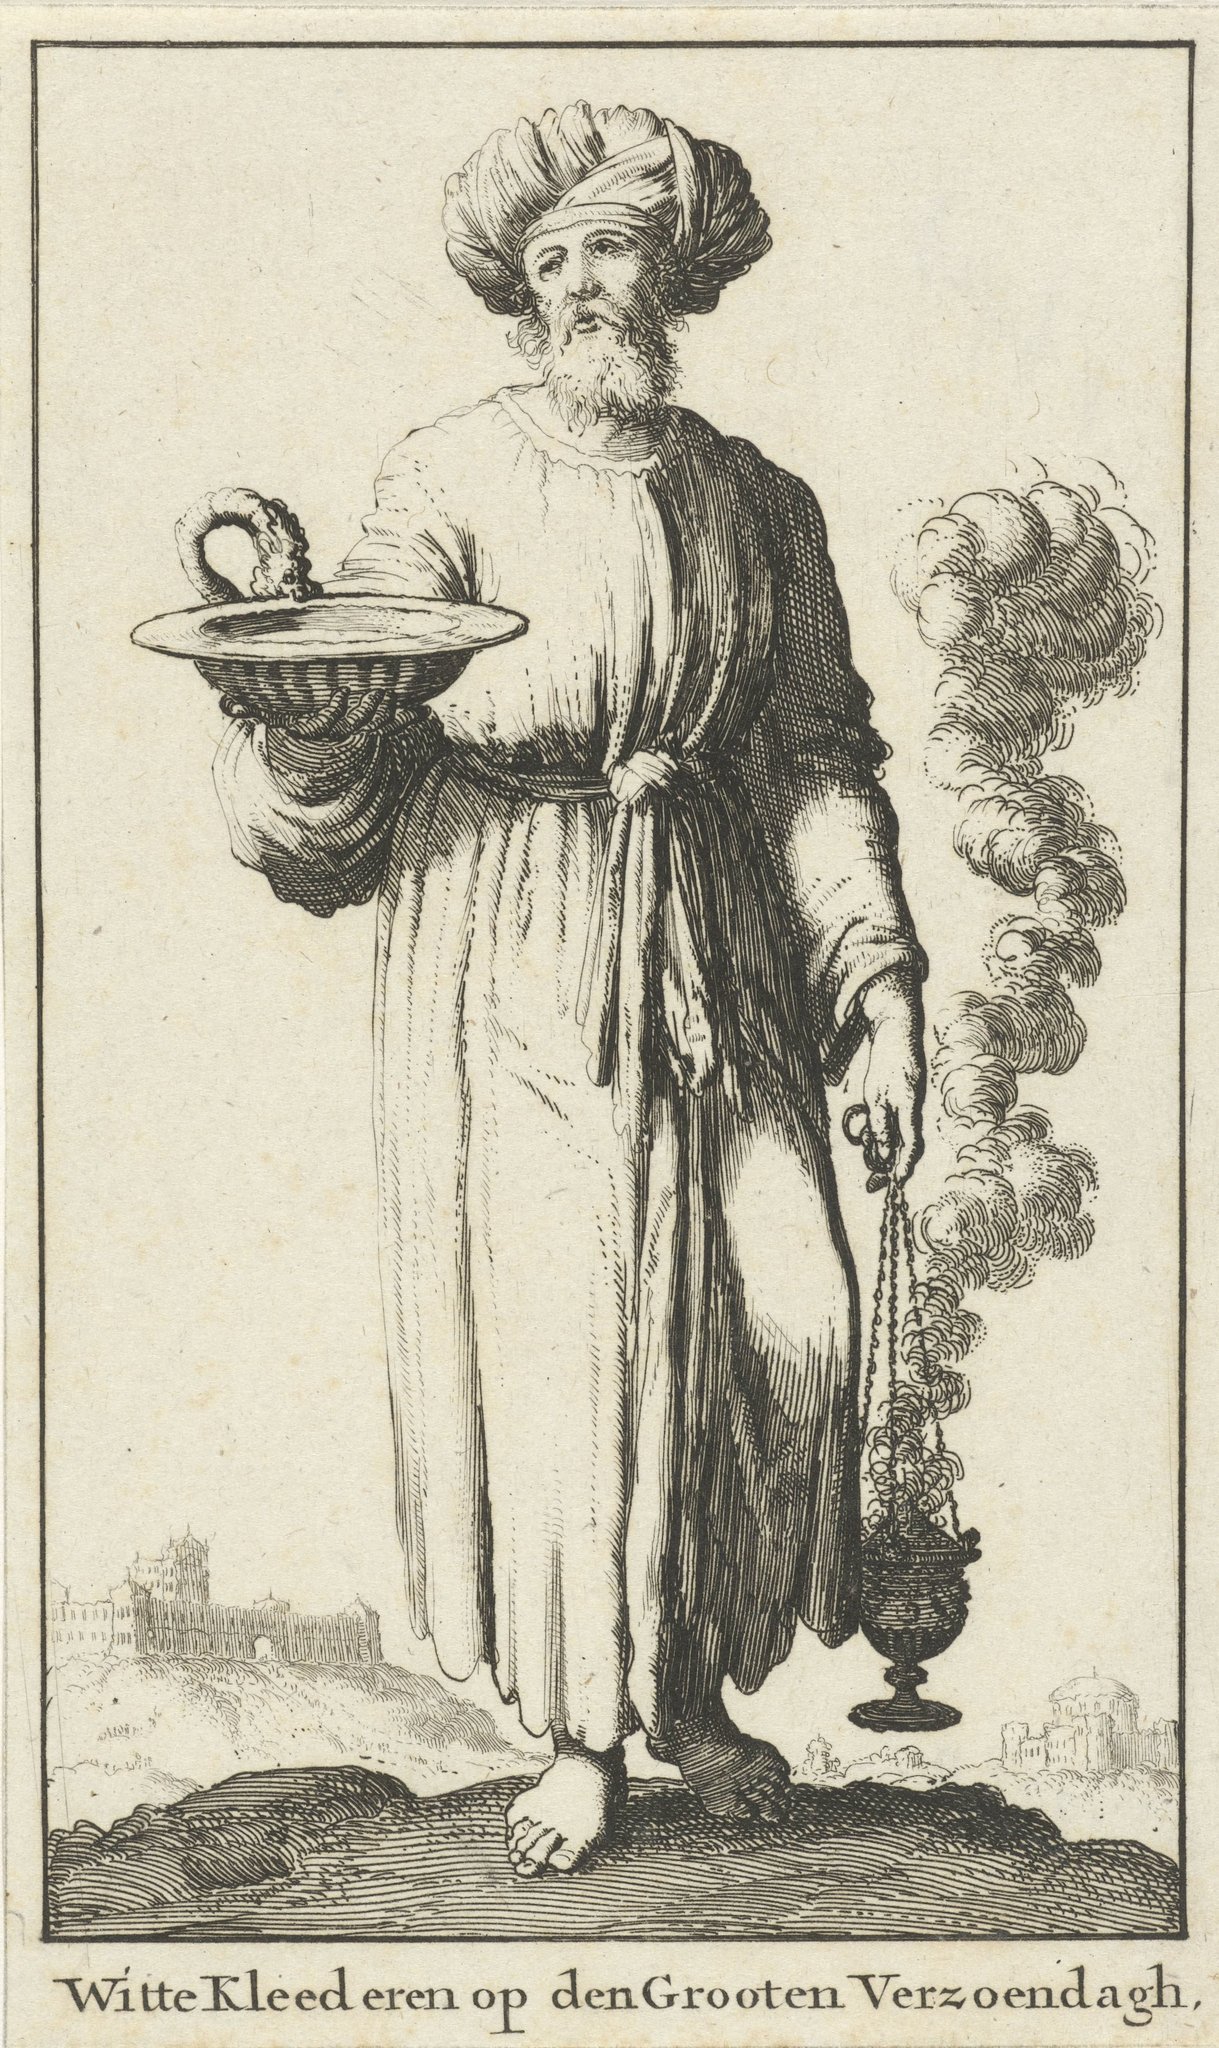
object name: book illustration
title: Hogepriester in witte liturgische kleding behorend bij de Grote Verzoendag (variant A)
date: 1682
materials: paper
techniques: etching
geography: amsterdam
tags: high priest ~ hierarchy of priests, 'yom kippur', day of atonement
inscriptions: collector's mark: Lugt 2228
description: Illustratie opgenomen in: Cunaeus, Petrus. De republyk der Hebreen, of gemeenebest der joden, 3 delen. Amsterdam: Wilhelmus Goeree, 1682, dl. 1, p. 168.